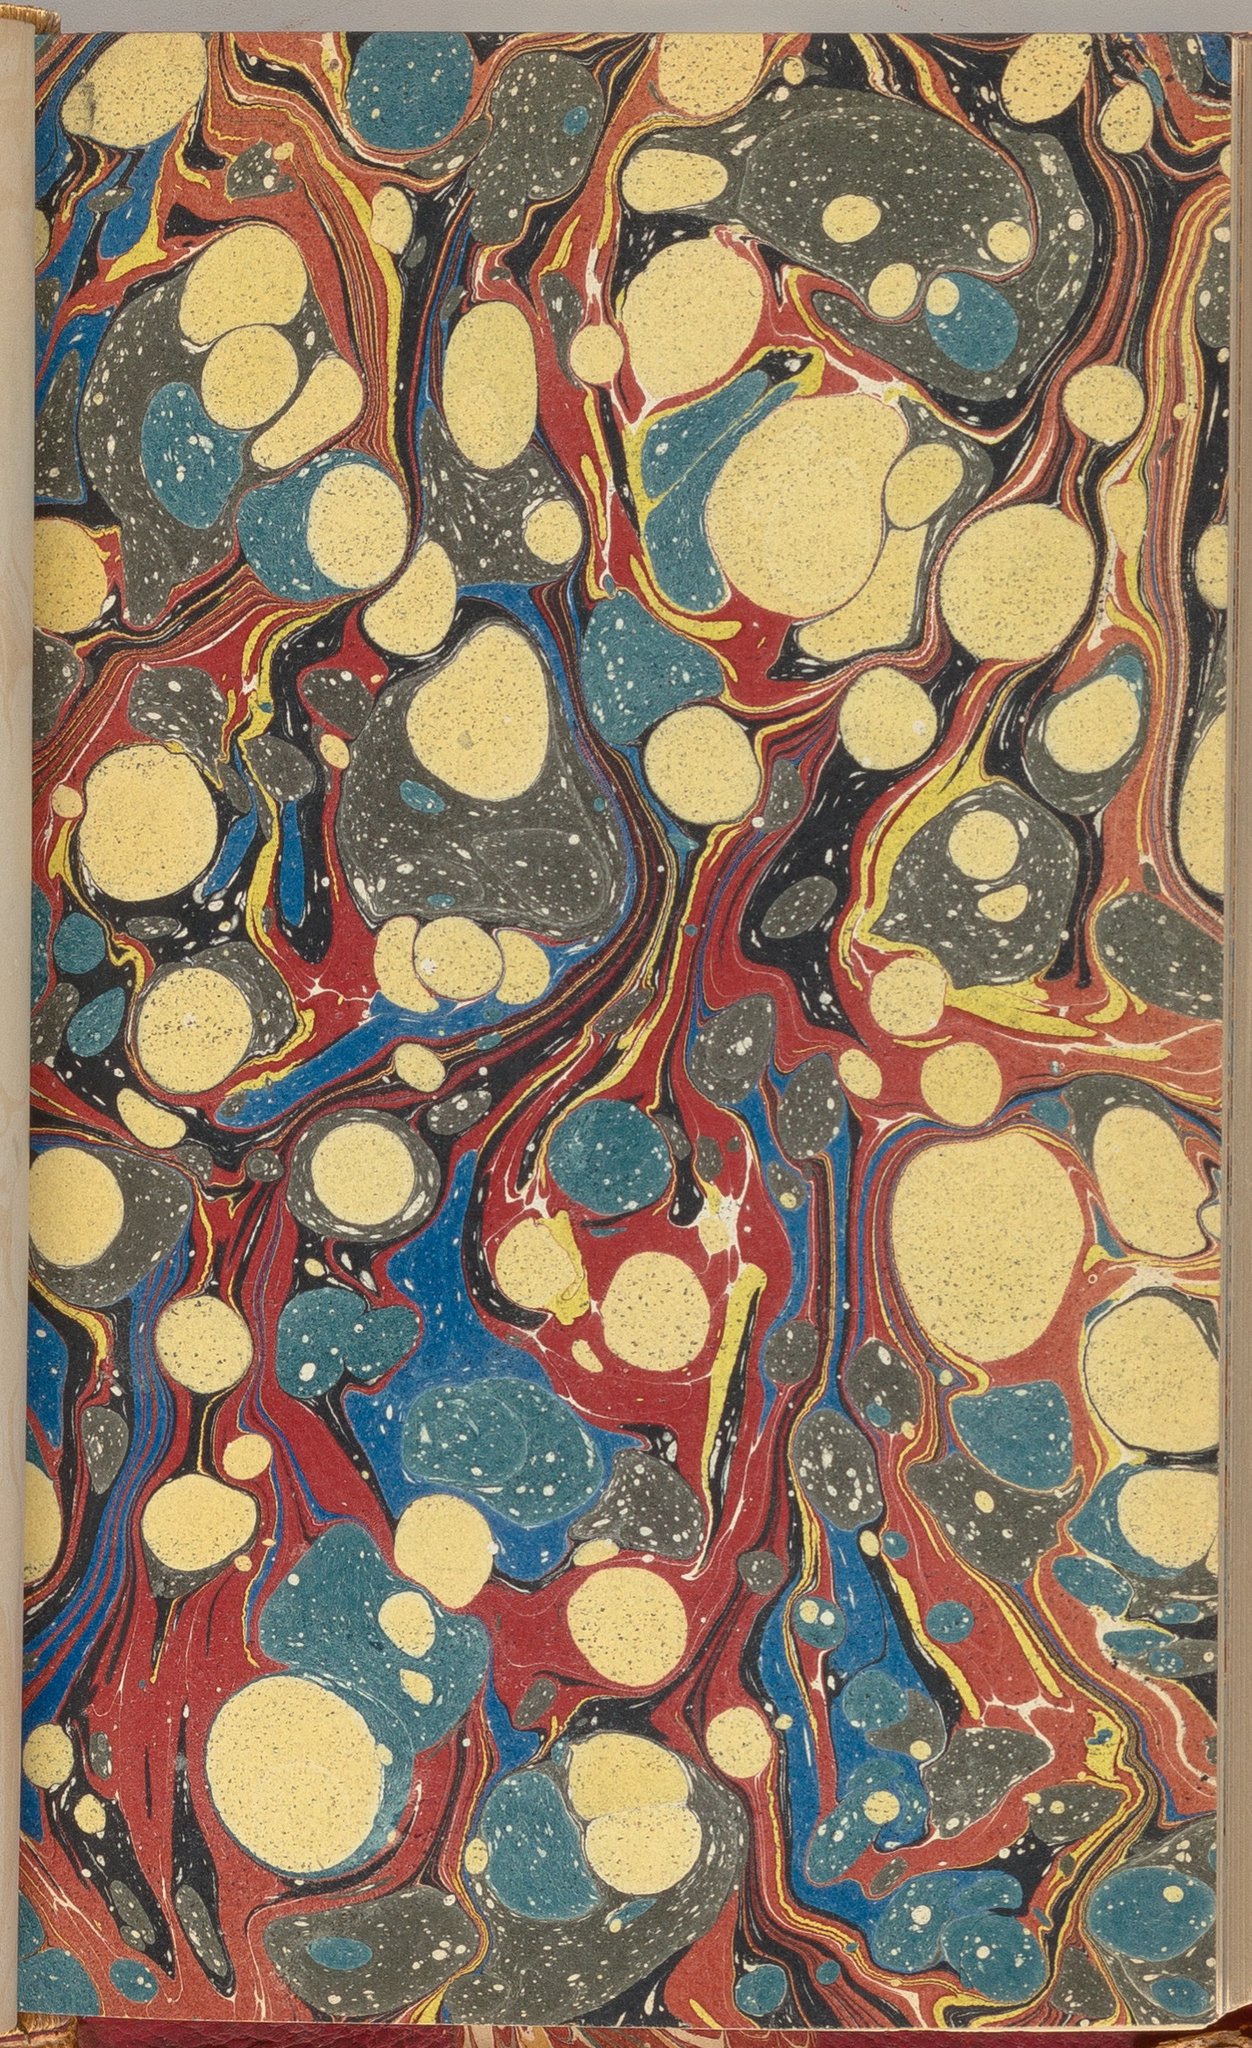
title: A manual of the art of bookbinding : containing full instructions in the different branches of forwarding, gilding, and finishing : also, the art of marbling book-edges and paper, the whole designed for the practical workman, the amateur, and the book-collector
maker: james bartram nicholson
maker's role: author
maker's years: 1820-1901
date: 1856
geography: united states